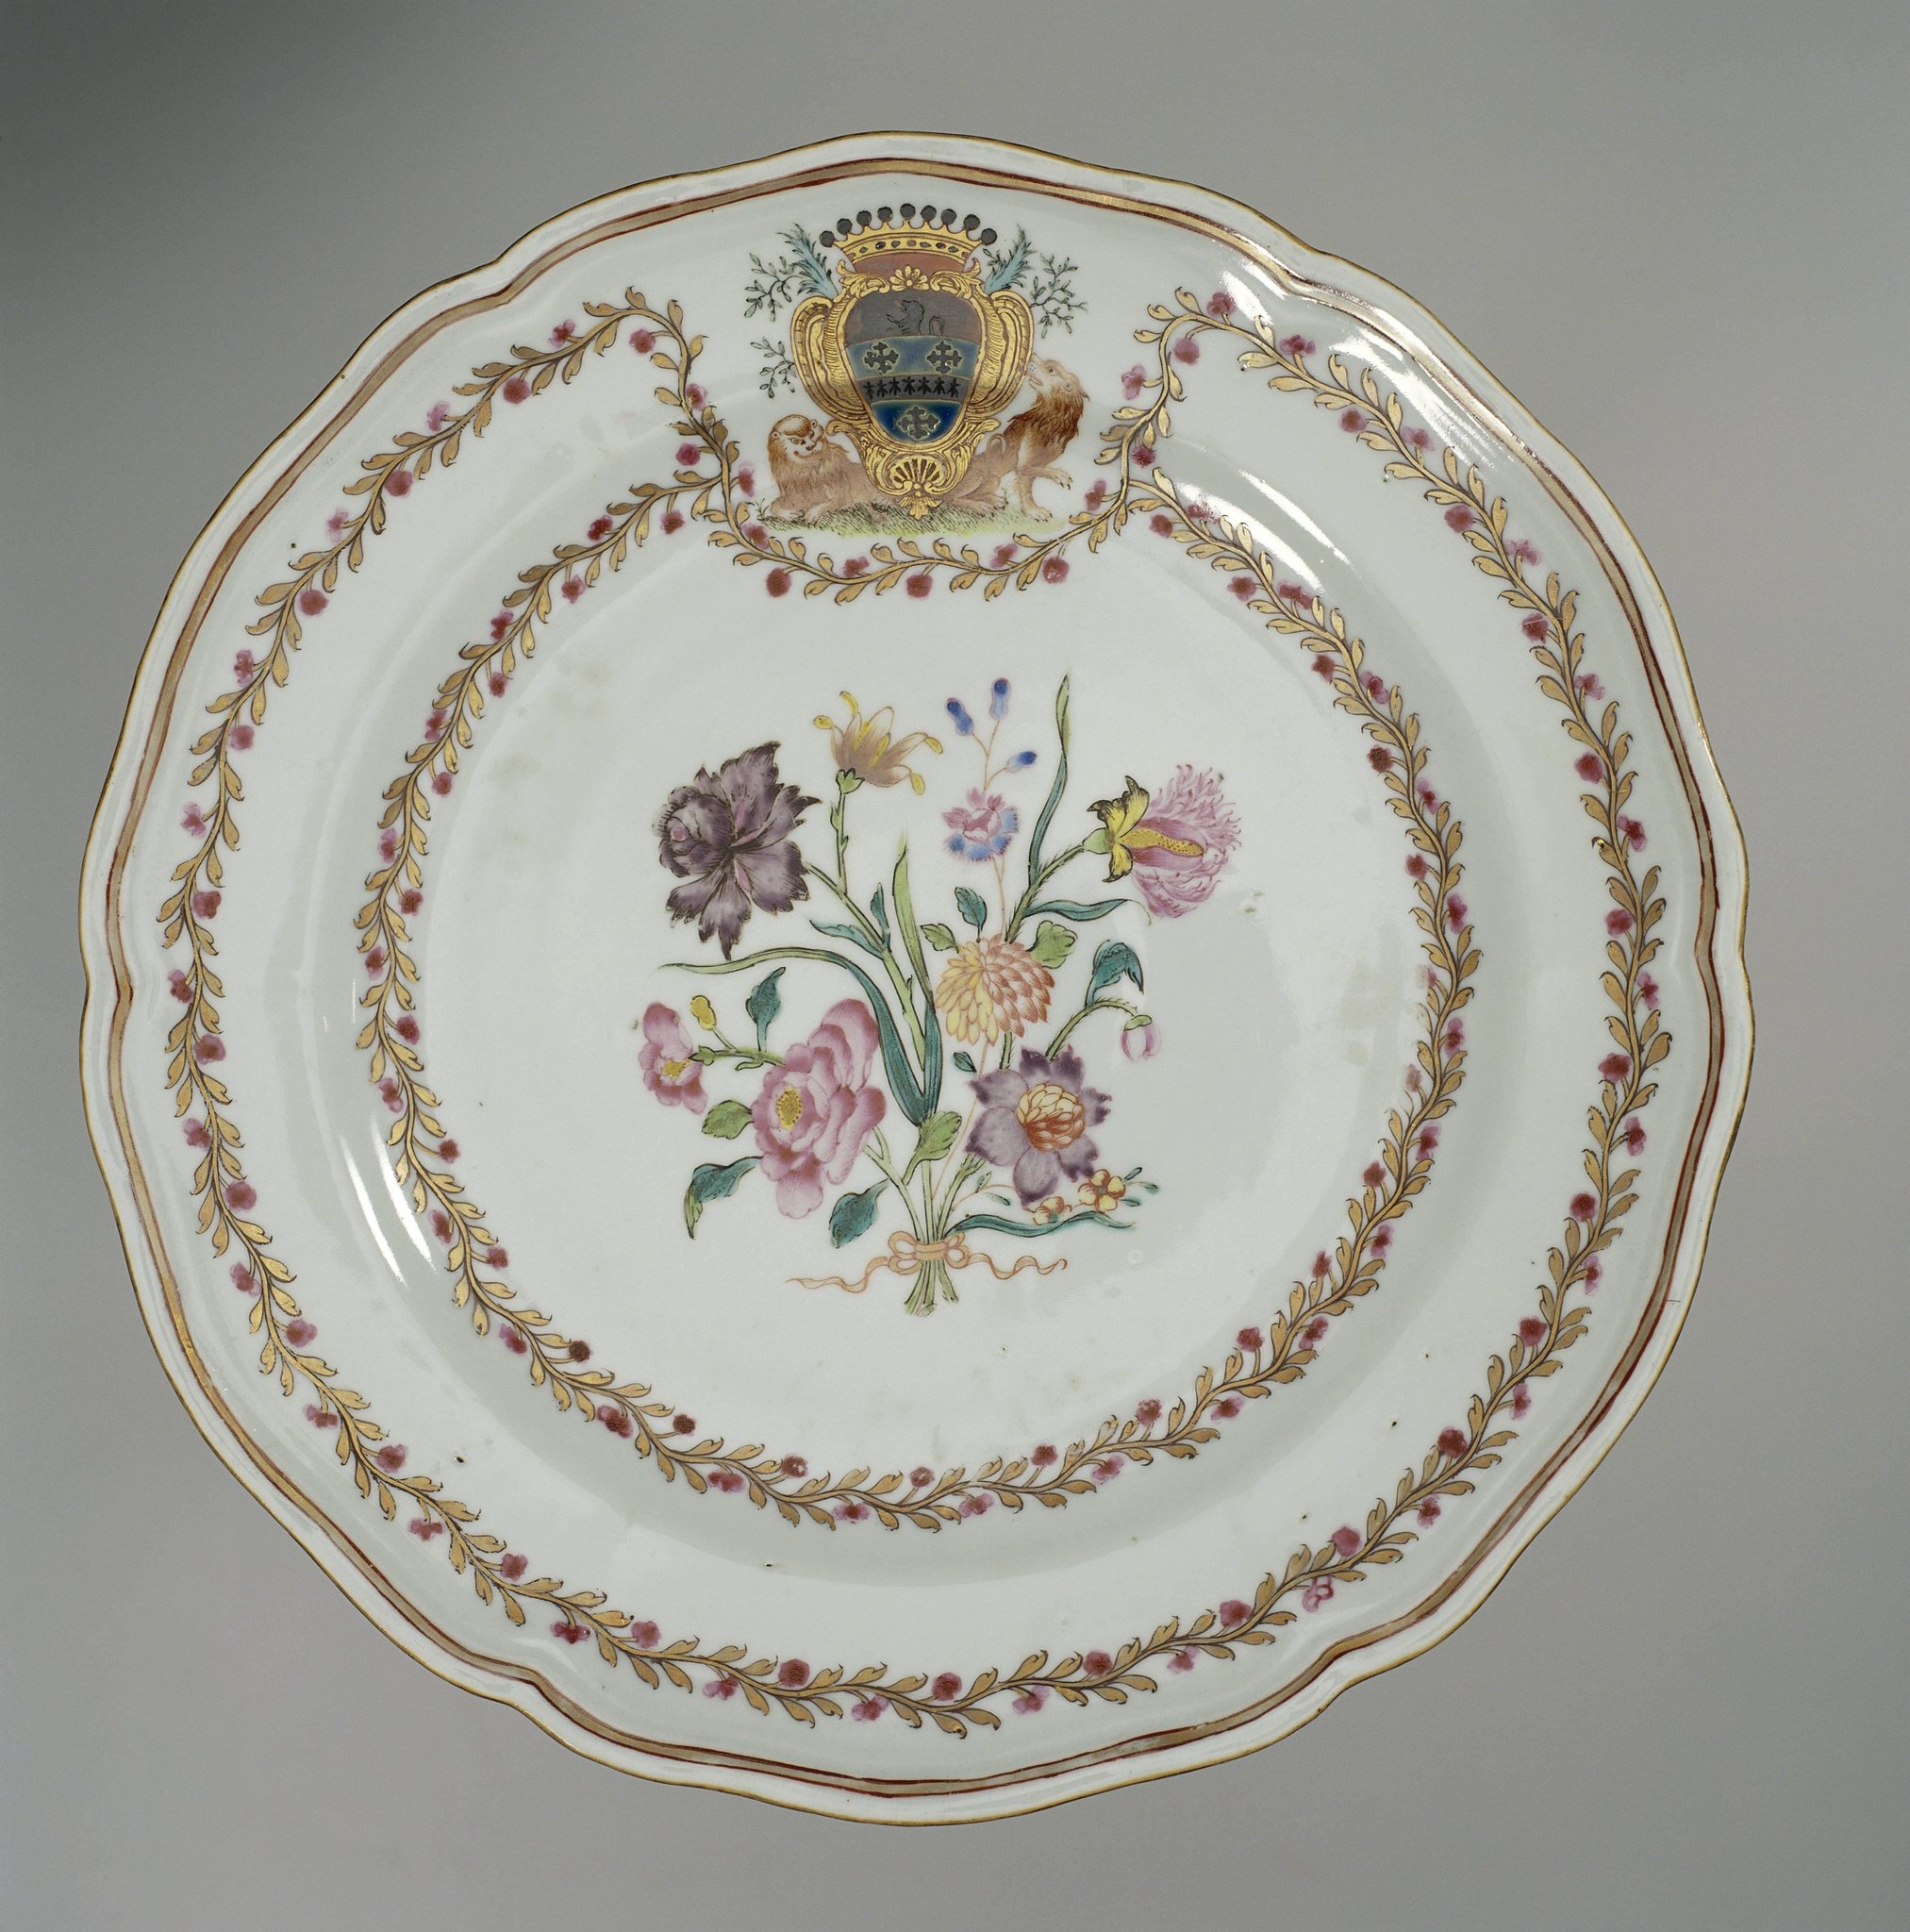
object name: plate dish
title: Plate with a bouquet of flowers and a crowned coat of arms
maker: Anonymous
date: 1775-1799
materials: glaze, gold, paint, porcelain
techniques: firing, gilding, turning, vitrification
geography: china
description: Bord van porselein met een geschulpte rand, beschilderd op het glazuur in blauw, rood, roze, groen, geel, paars, zwart en goud. Op het plat een boeket van bloemen. Op de wand en de rand een ongeïdentificeerd gekroond wapen, geflankeerd door leeuwen; op de wand en rand een doorlopende bloemrank. Wapenporselein met emailkleuren.